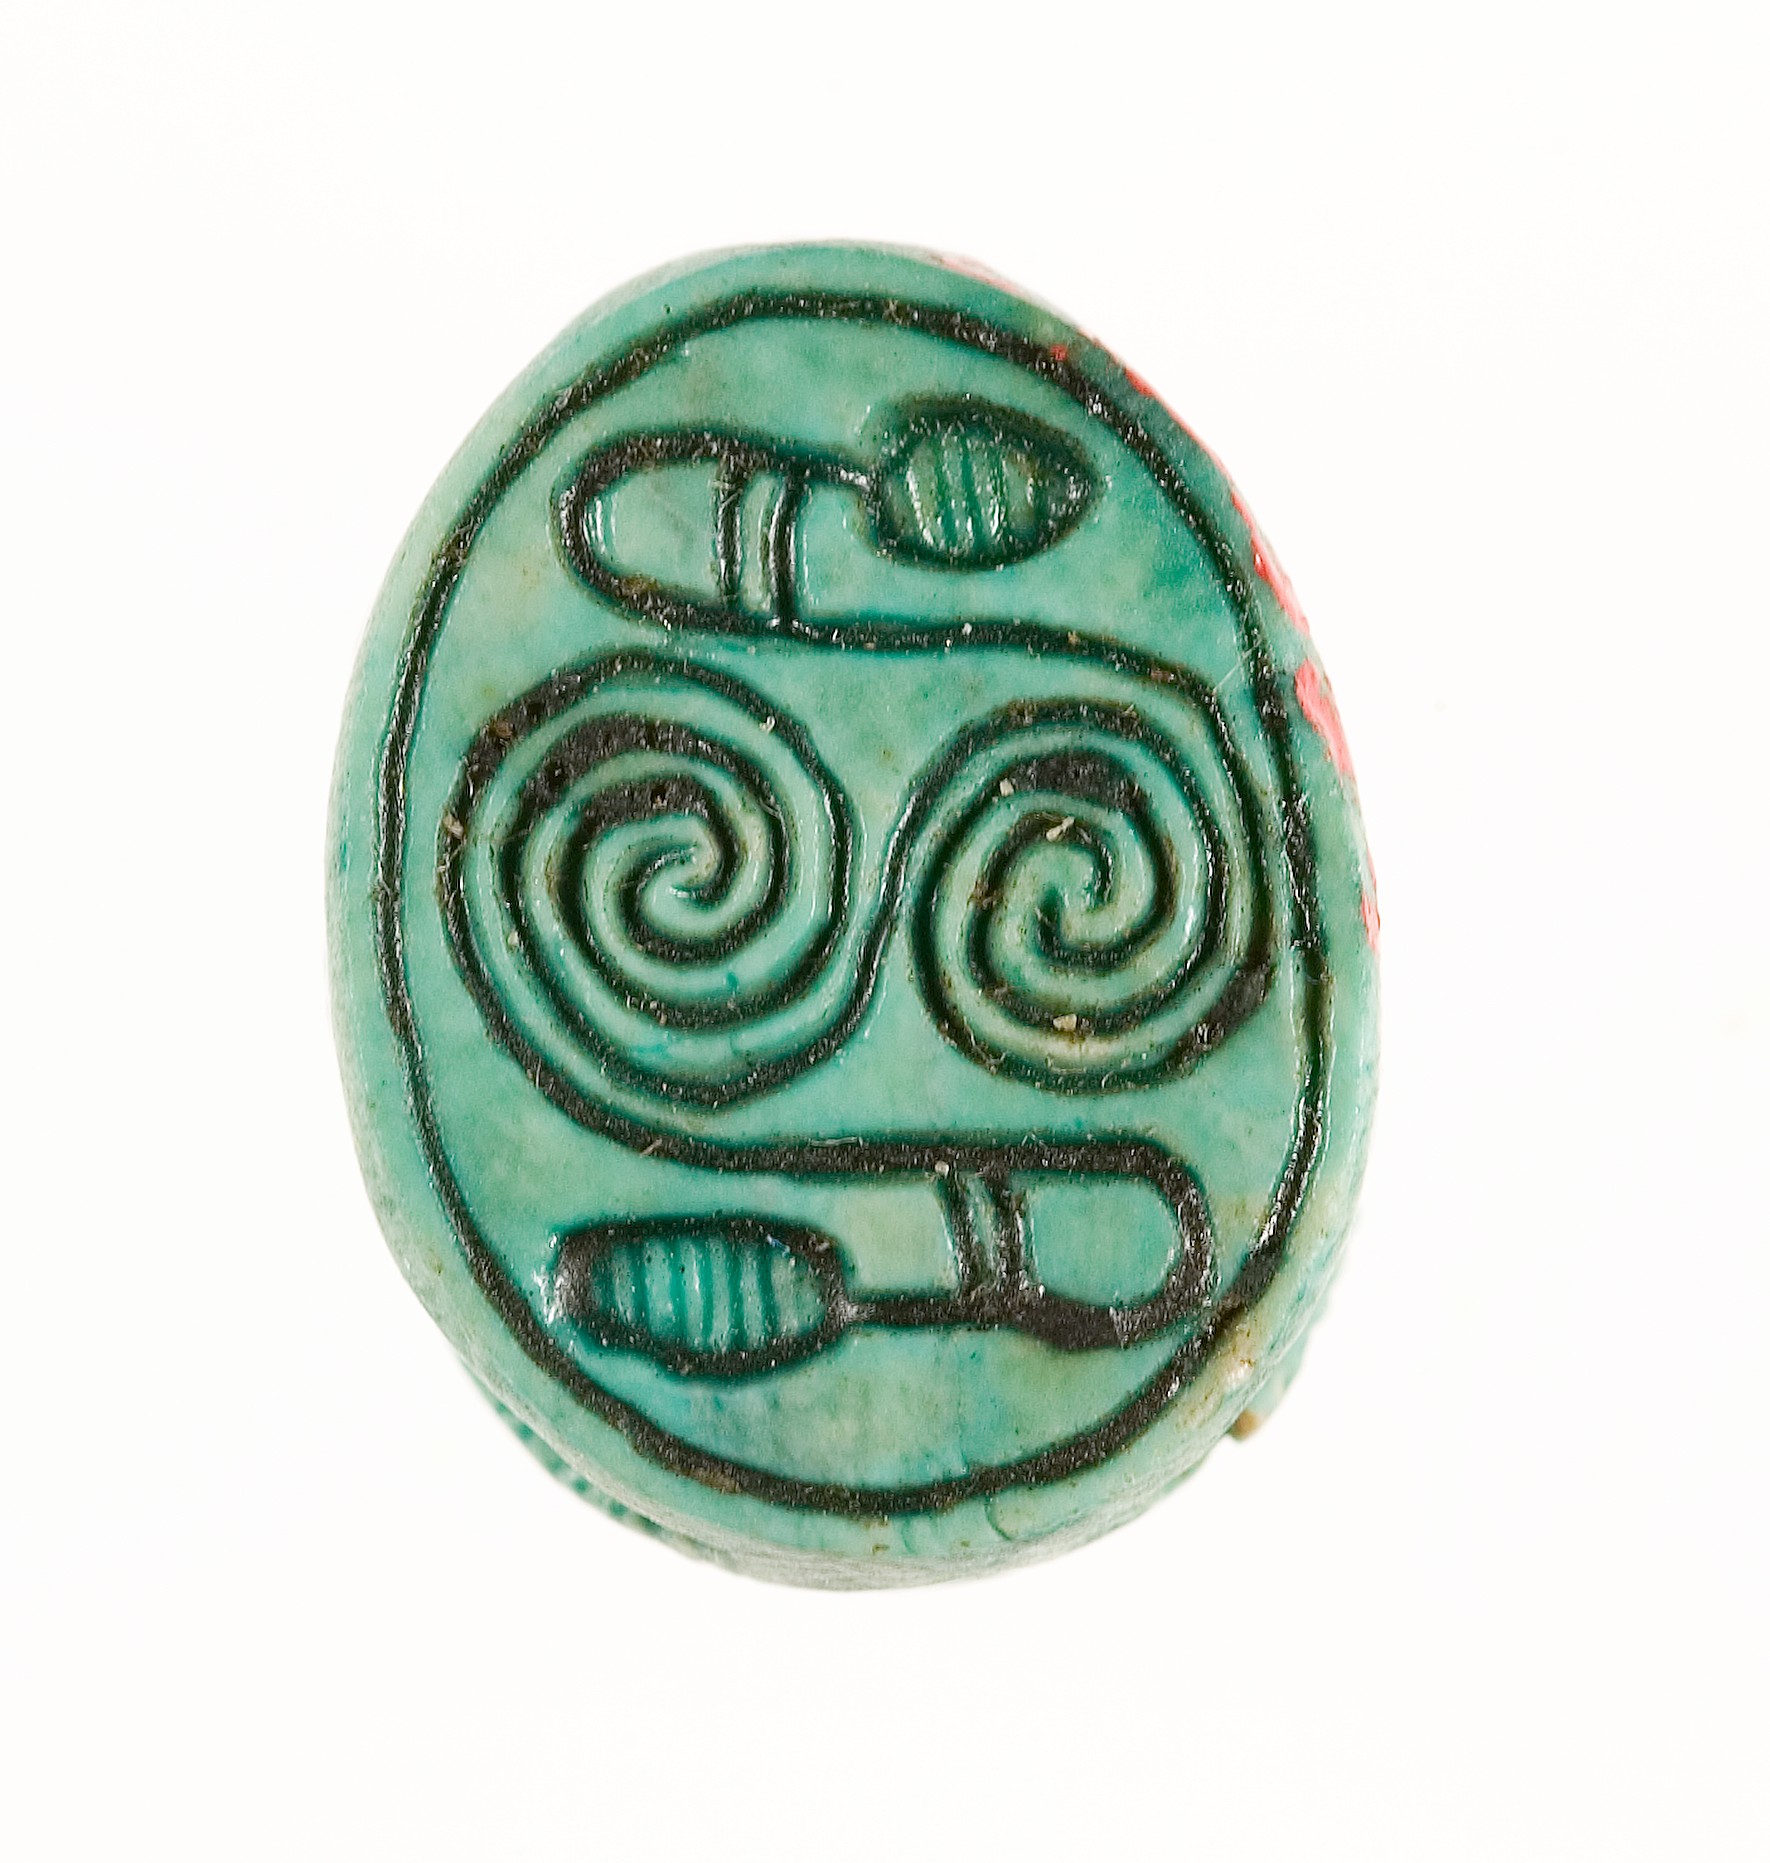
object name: scarab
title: Scarab Inscribed with a Geometric Pattern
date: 1479-1458 BCE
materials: stone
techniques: glazing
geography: egypt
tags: scarabs